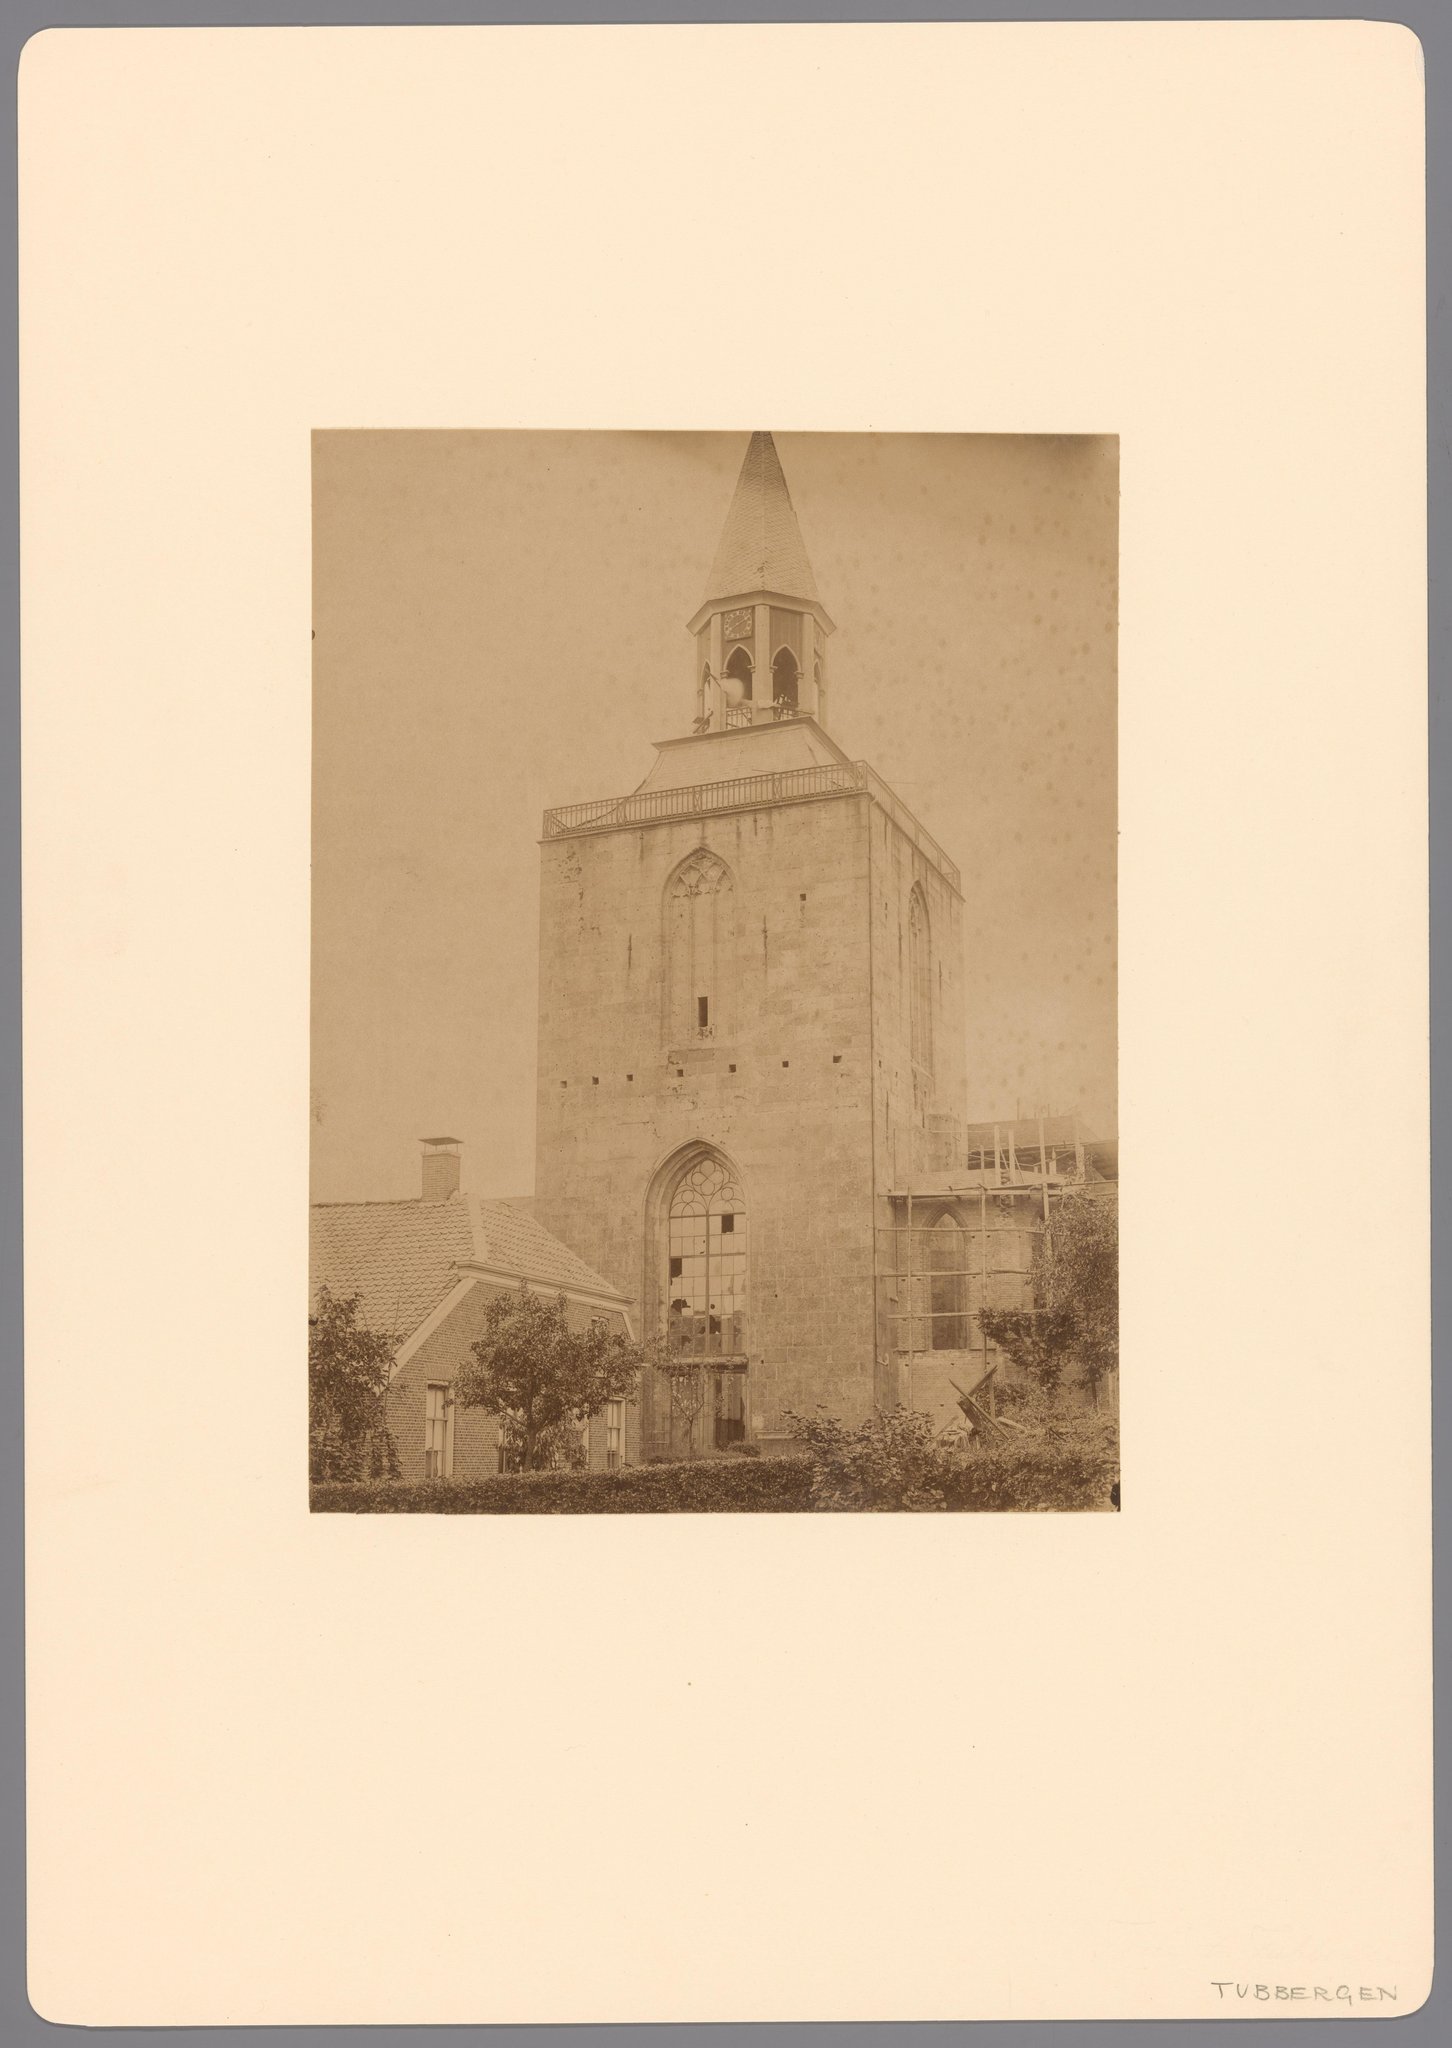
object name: photograph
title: Toren van de Sint-Pancratiusbasiliek te Tubbergen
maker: anoniem (monumentenzorg)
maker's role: fotograaf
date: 1890-1910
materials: cardboard, photographic support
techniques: albumen print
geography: tubbergen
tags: parts of church exterior and annexes: tower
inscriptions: annotation: ‘Tubbergen’, annotation: ‘Tubbergen/ toren’